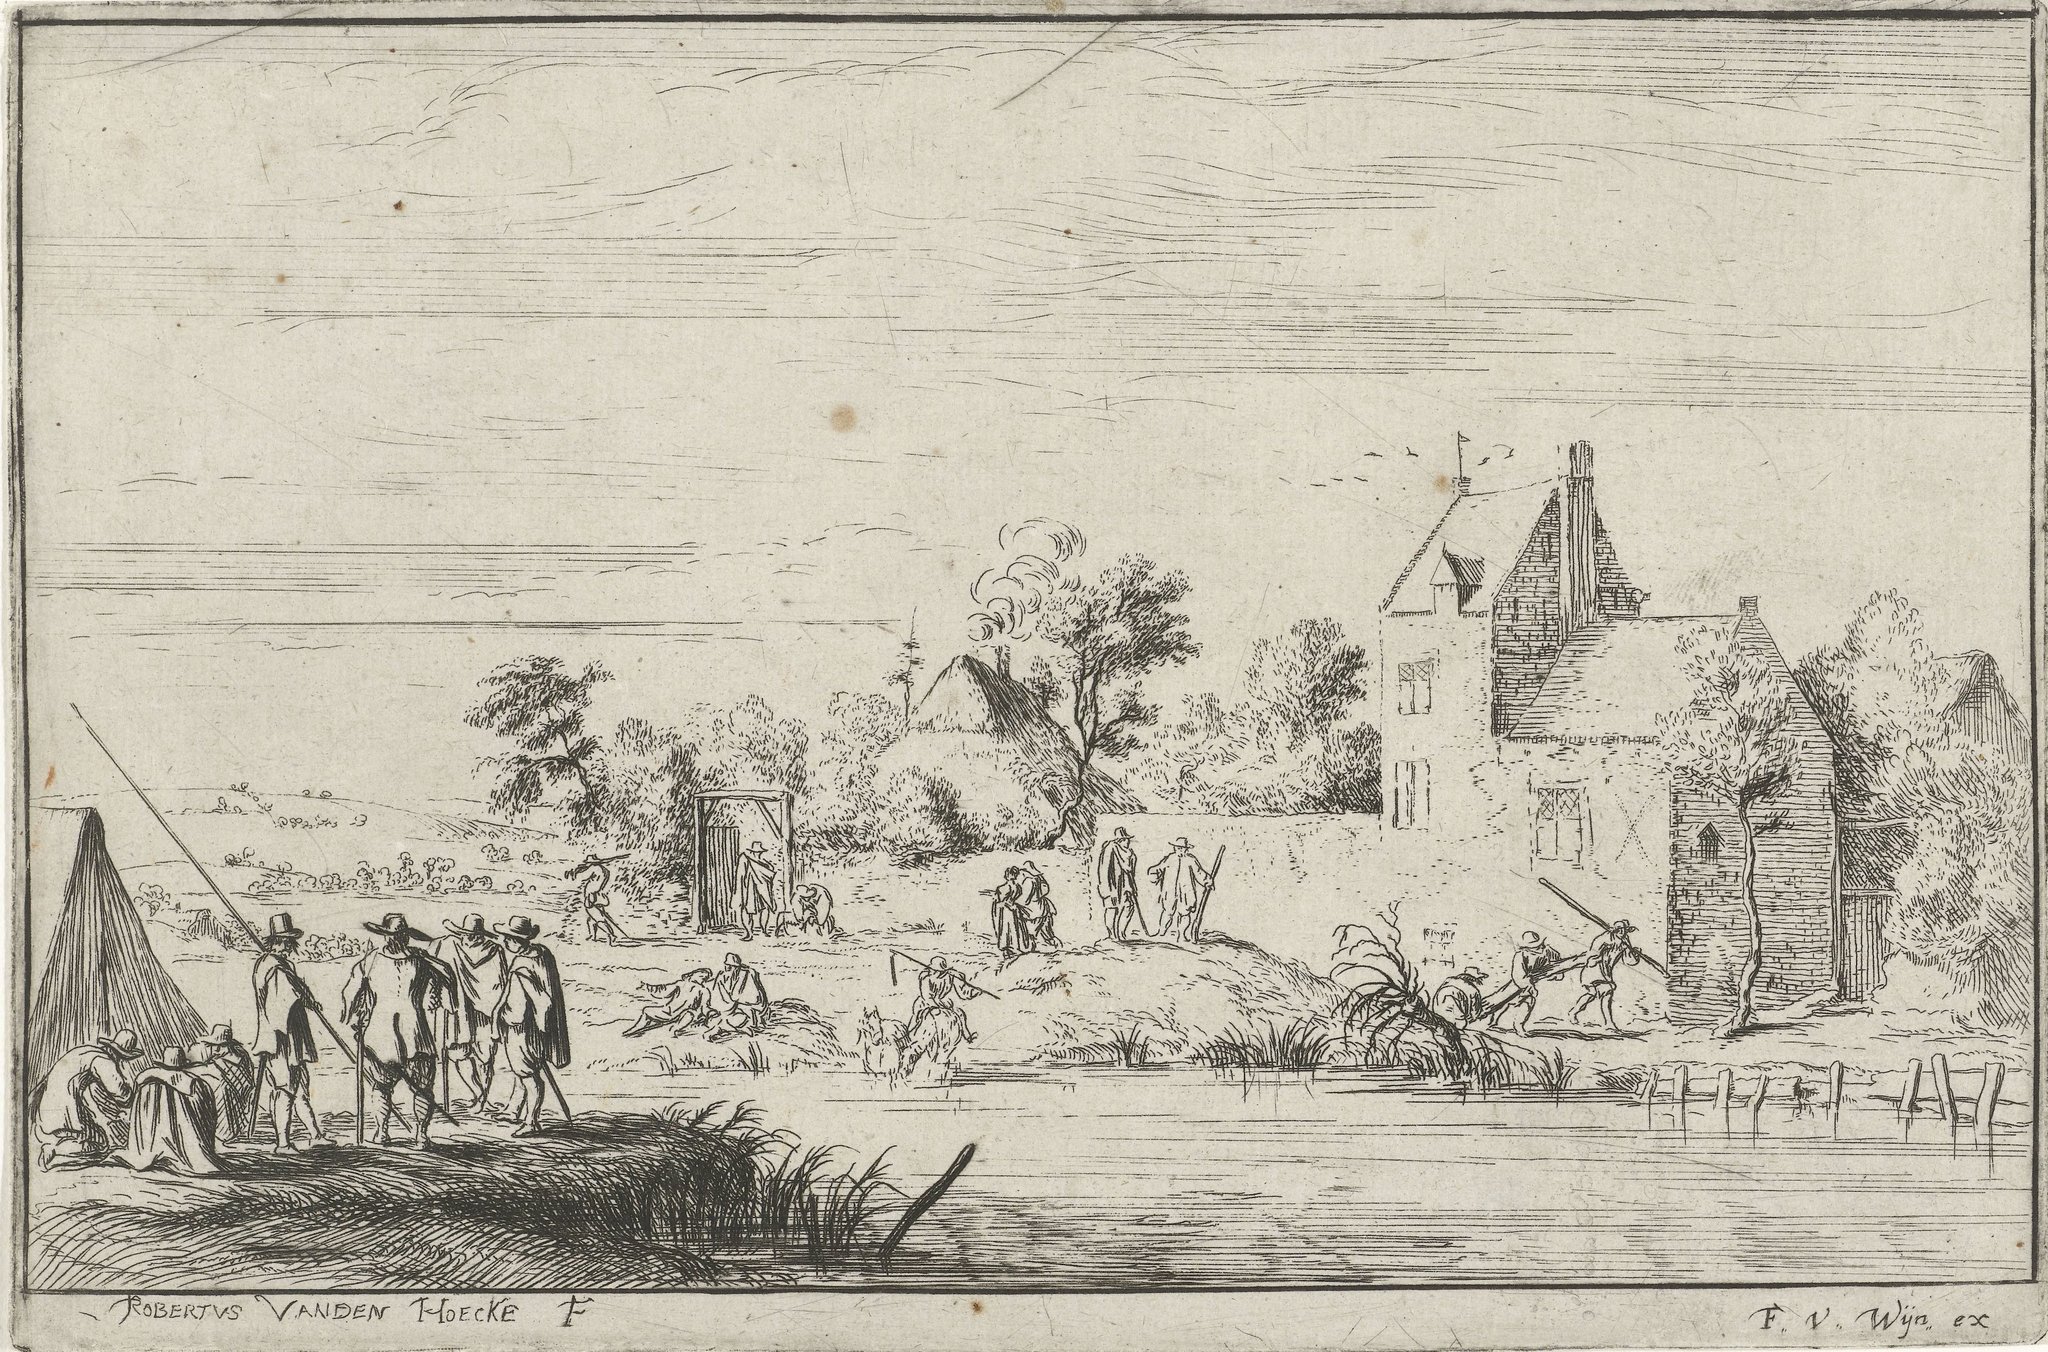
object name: print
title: Soldaten op een rivieroever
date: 1632-1679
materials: paper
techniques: engraving, etching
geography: antwerp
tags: the soldier; the soldier's life, the soldier off duty, farm or solitary house in landscape (+ city(-scape) with figures, staffage), landscapes with waters, waterscapes, seascapes (in the temperate zone) (+ landscape with figures, staffage)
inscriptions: collector's mark: Lugt 240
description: Verschillende groepen soldaten bij een weg, links op de voorgrond rustende soldaten bij een tent, rechts soldaten bij een huis.